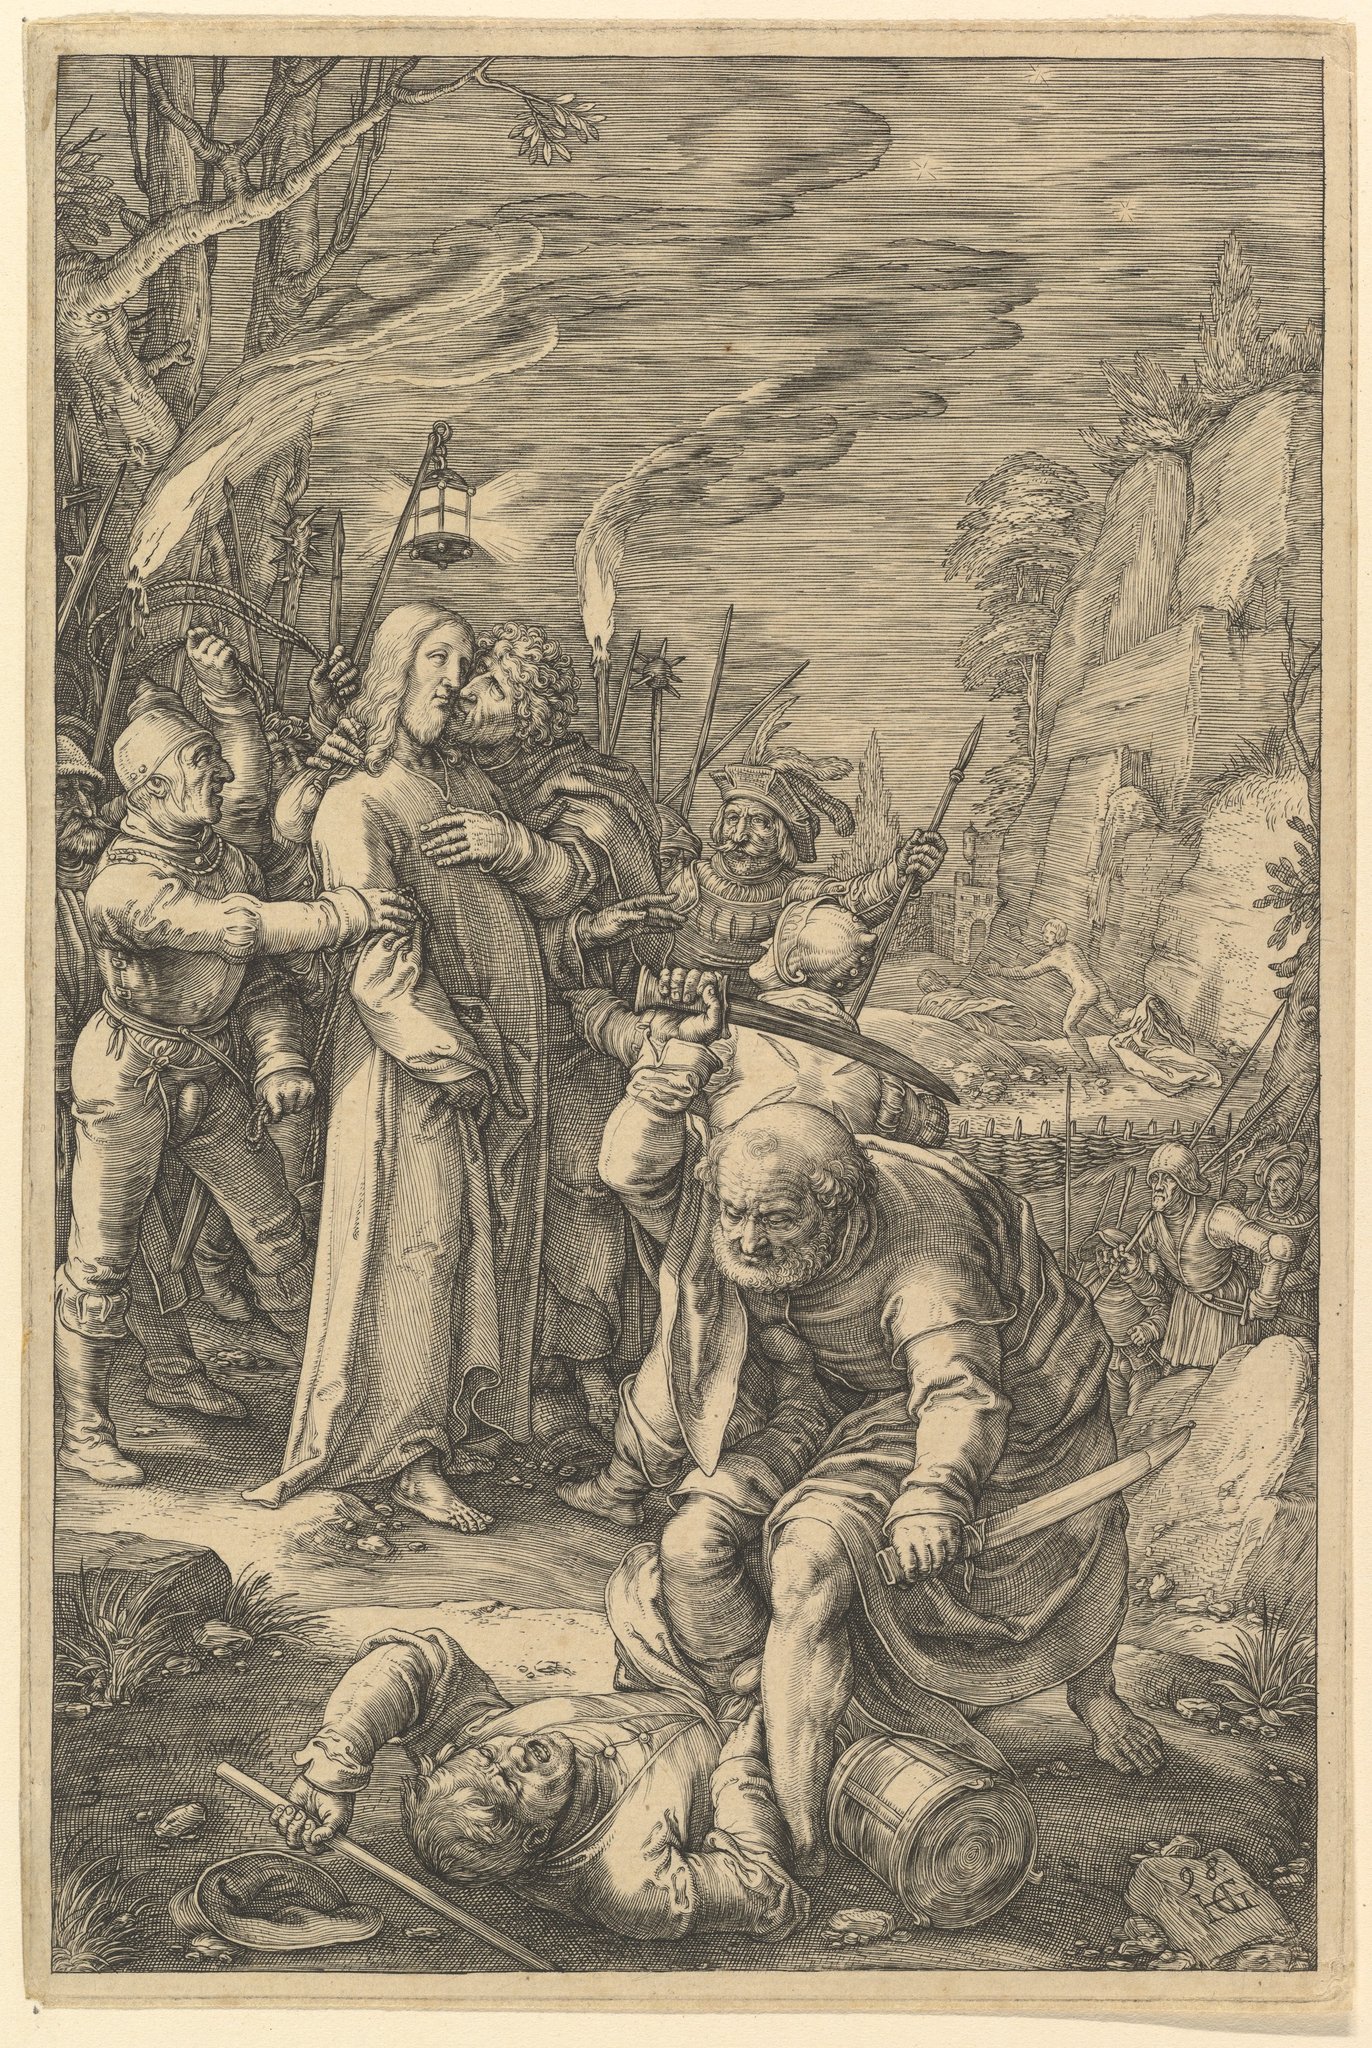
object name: print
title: The Betrayal of Christ, from "The Passion of Christ"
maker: hendrick goltzius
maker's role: artist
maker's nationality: netherlandish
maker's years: 1558-1617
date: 1598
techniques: engraving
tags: daggers,men,apostles,christ